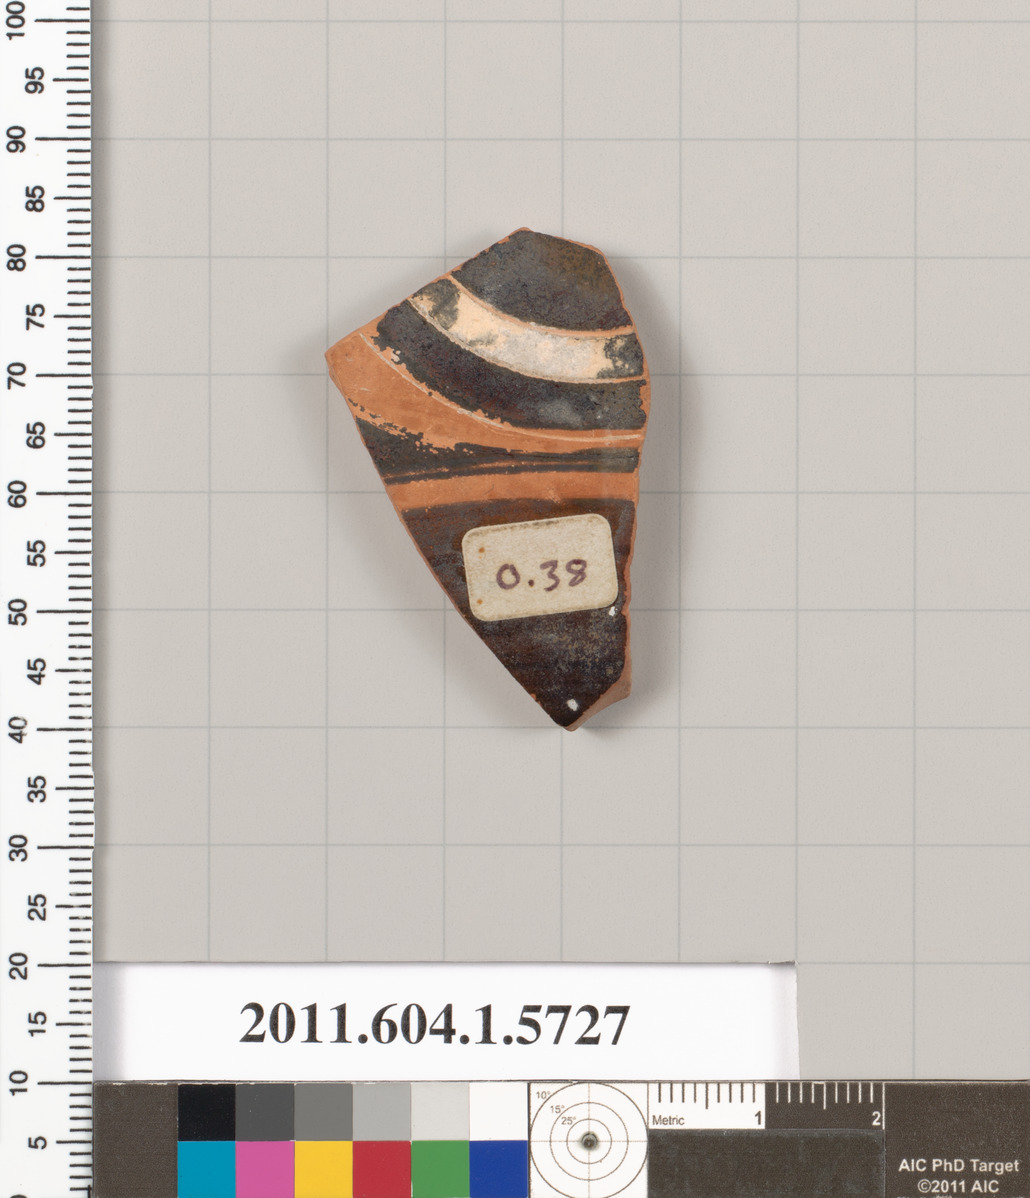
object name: kylix fragment, eye cup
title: Terracotta fragment of a kylix: eye-cup (drinking cup)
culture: greek, attic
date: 525-515 BCE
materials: terracotta